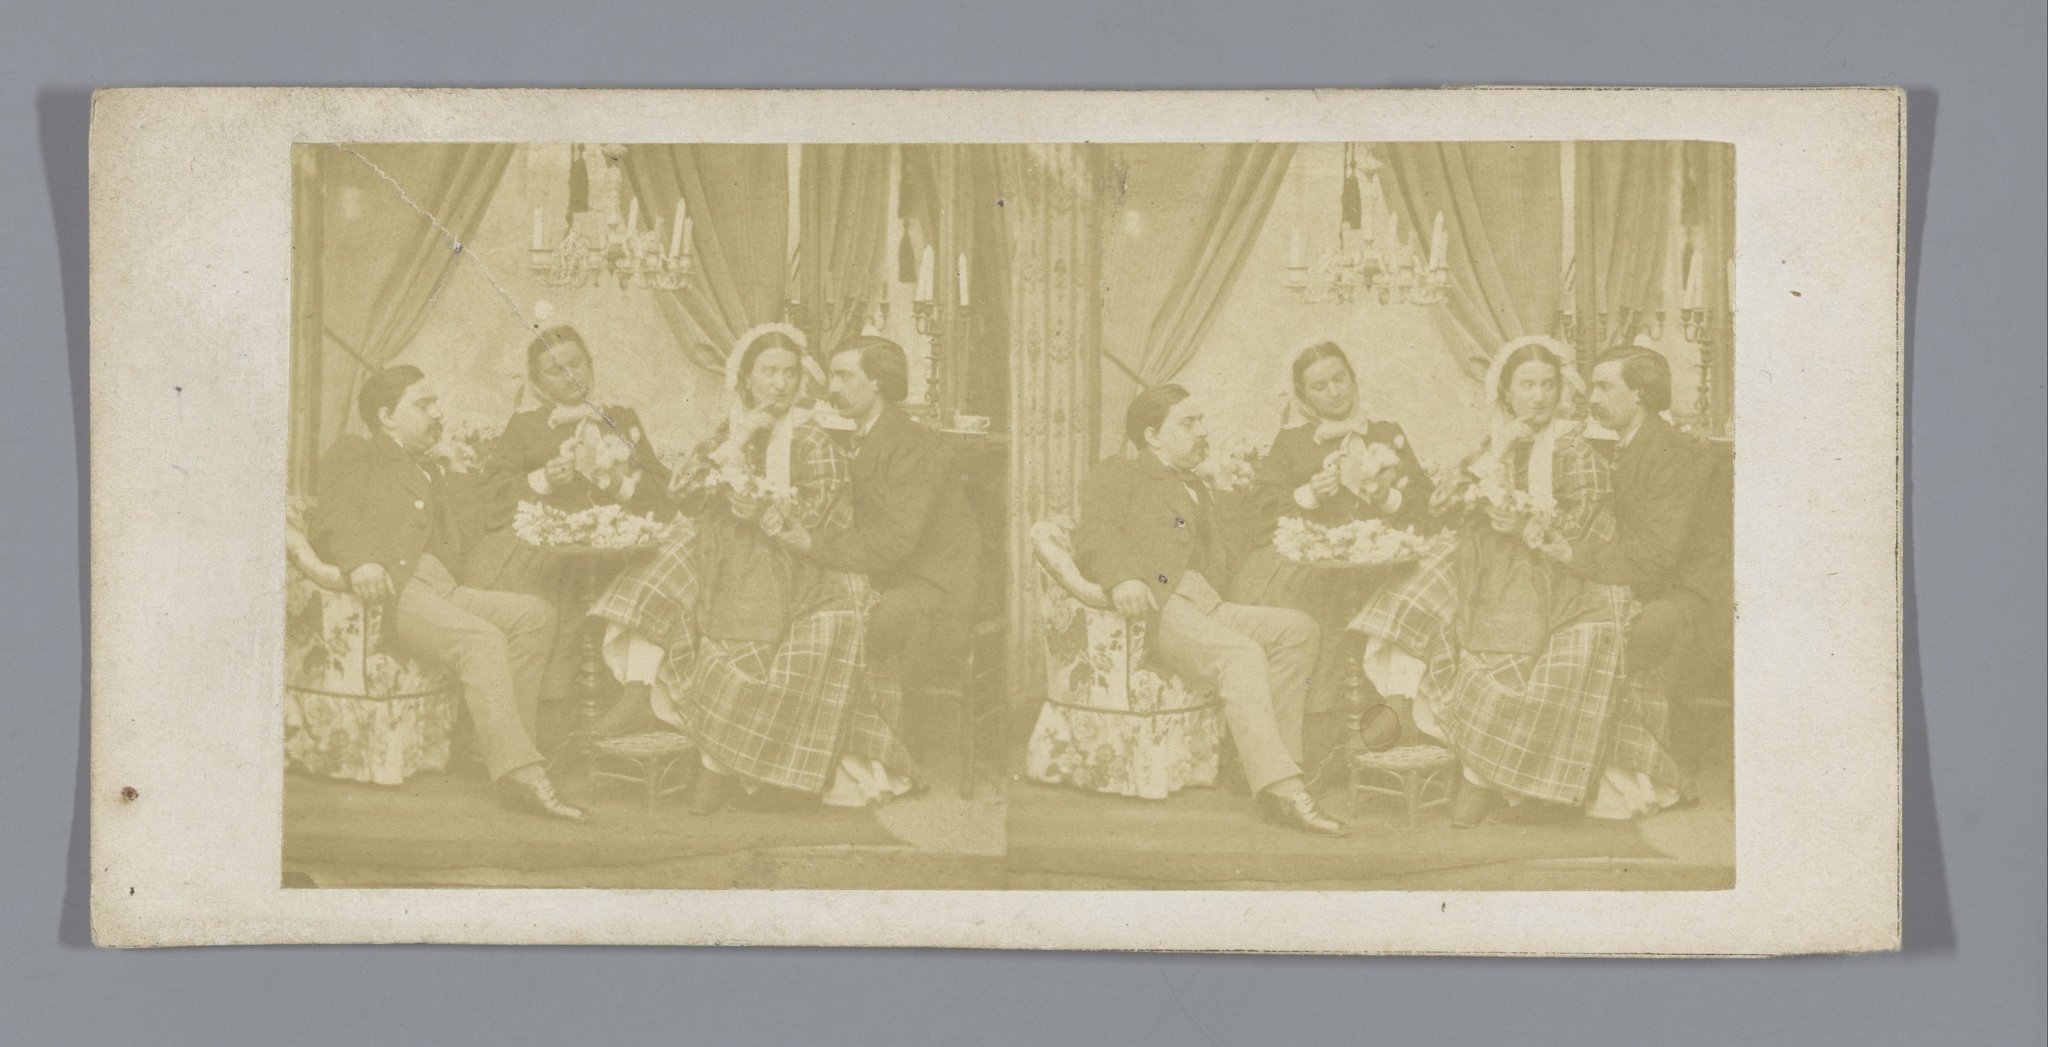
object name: stereograph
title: Twee paren rond een tafel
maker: Anonymous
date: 1850-1880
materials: cardboard, photographic support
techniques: albumen print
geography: europe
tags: living-room, parlour, sitting-room, europe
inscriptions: number: ‘No. 44.’